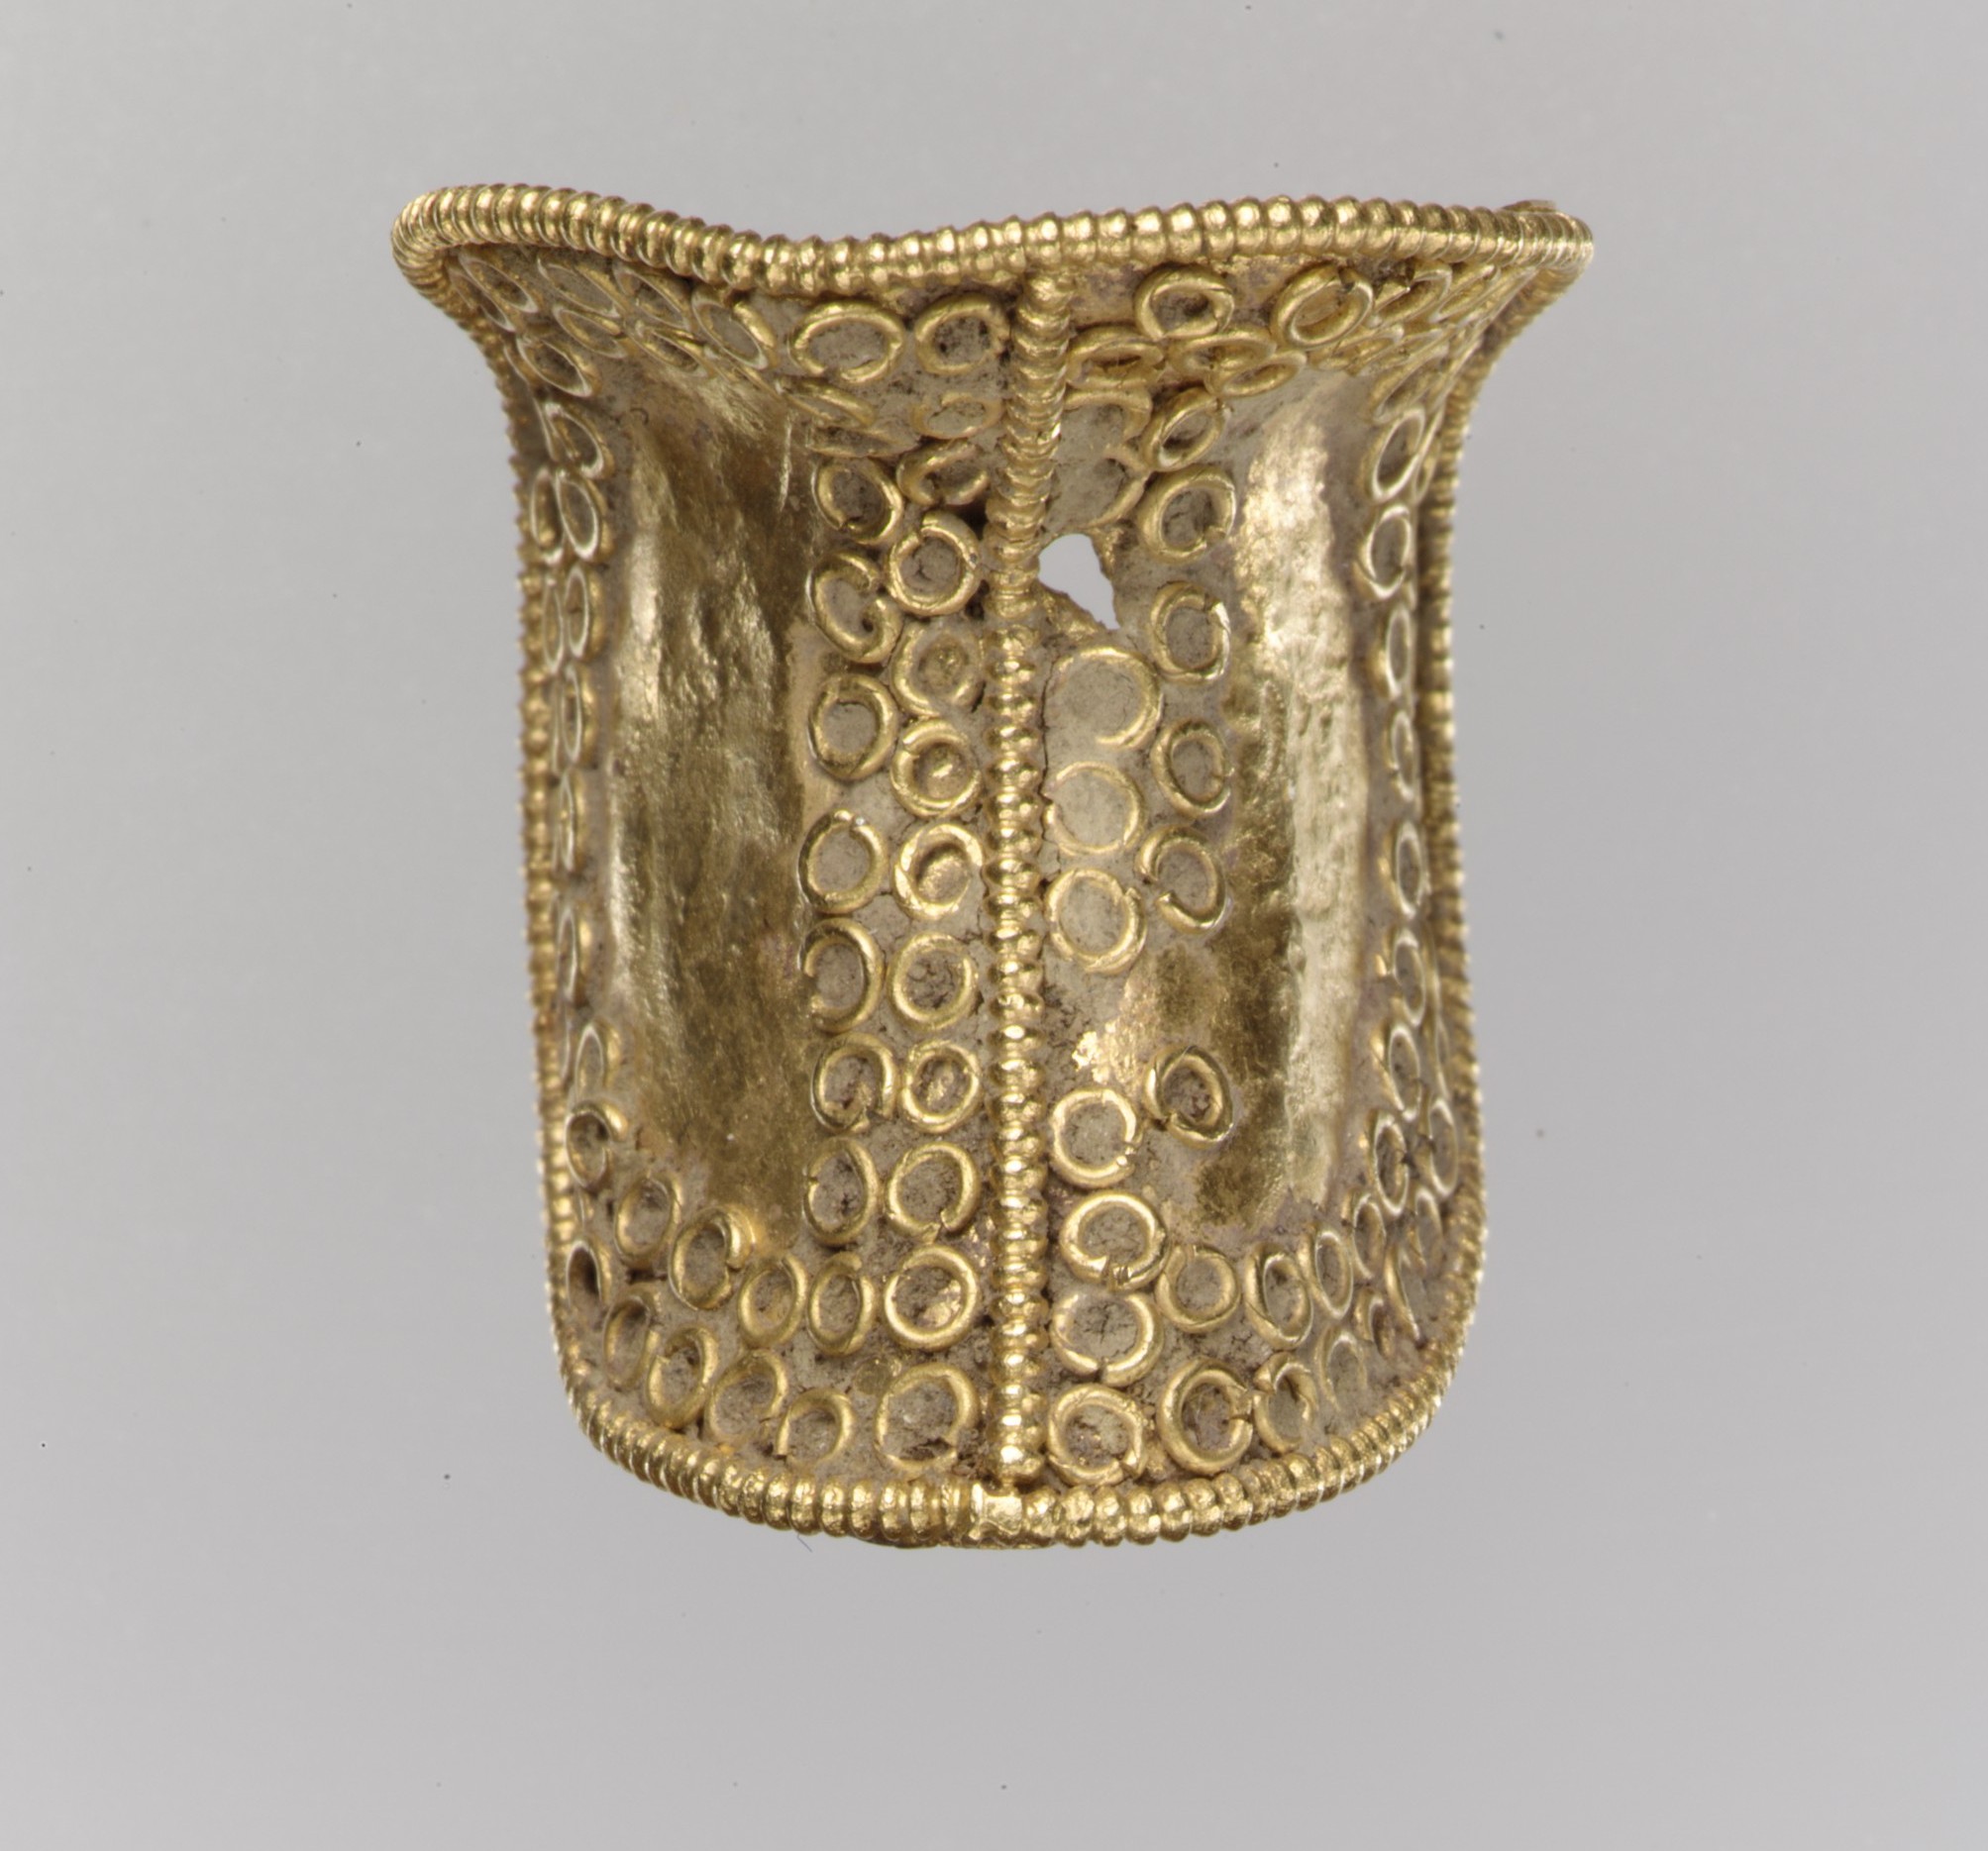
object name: sword grip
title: Gold Ornament from a Sword Grip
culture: langobardic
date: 600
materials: gold